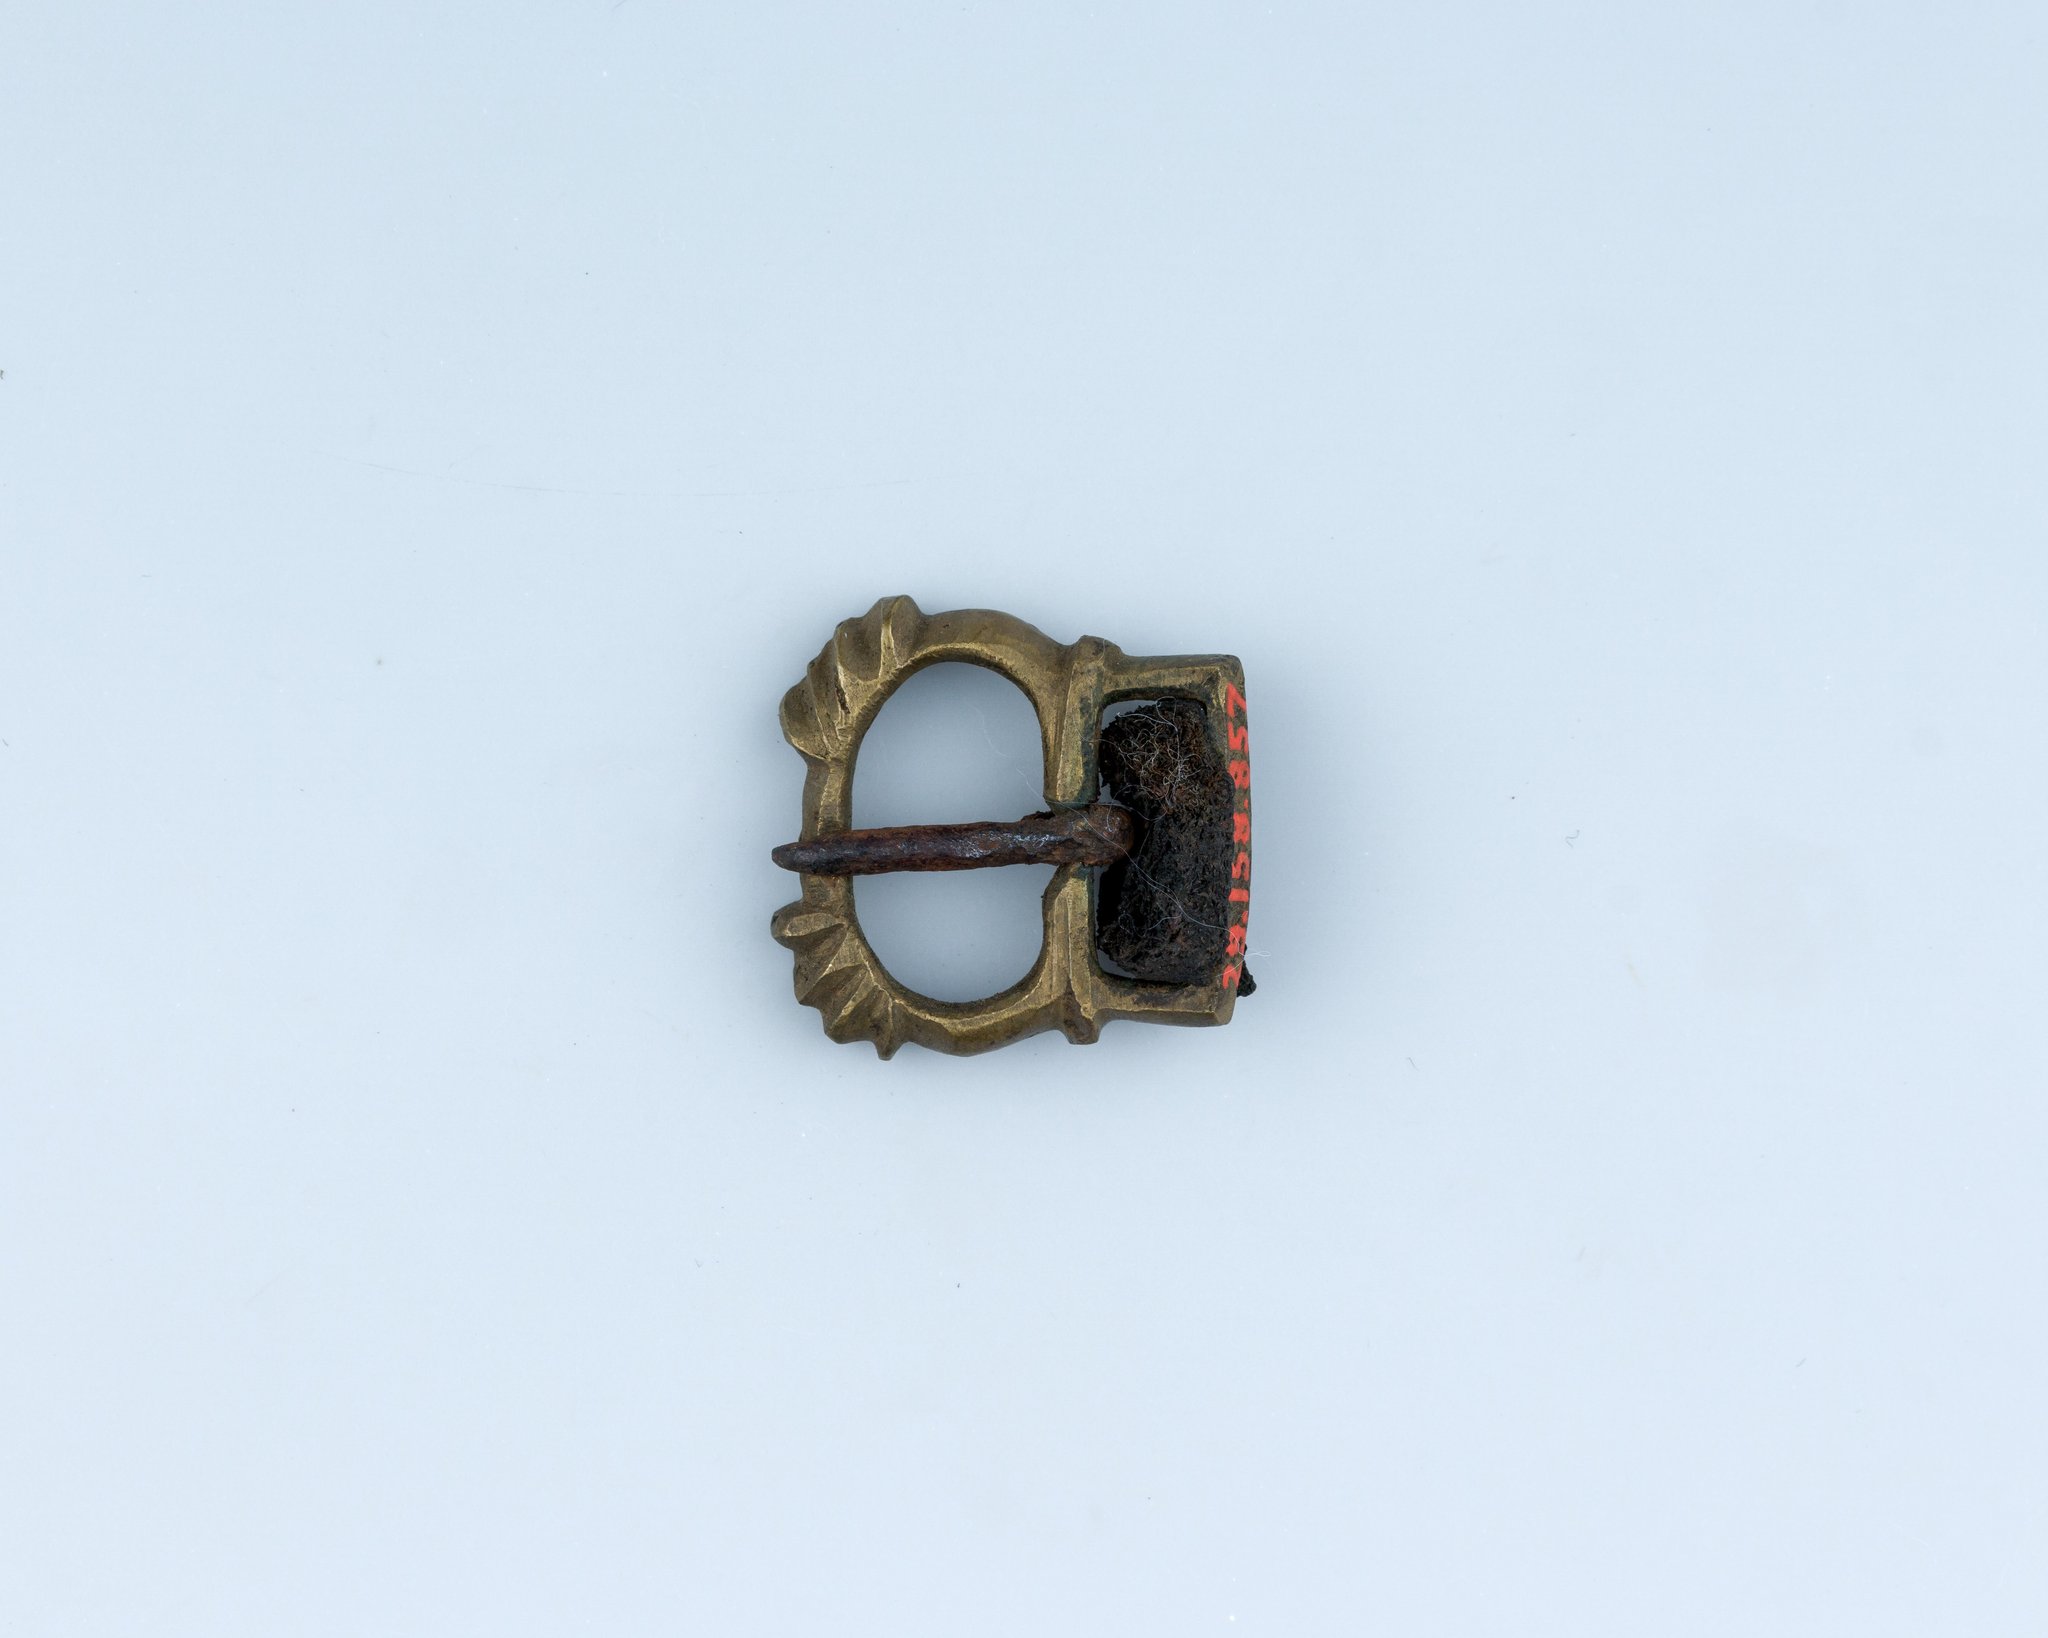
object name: buckle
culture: european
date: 1401-1700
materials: brass